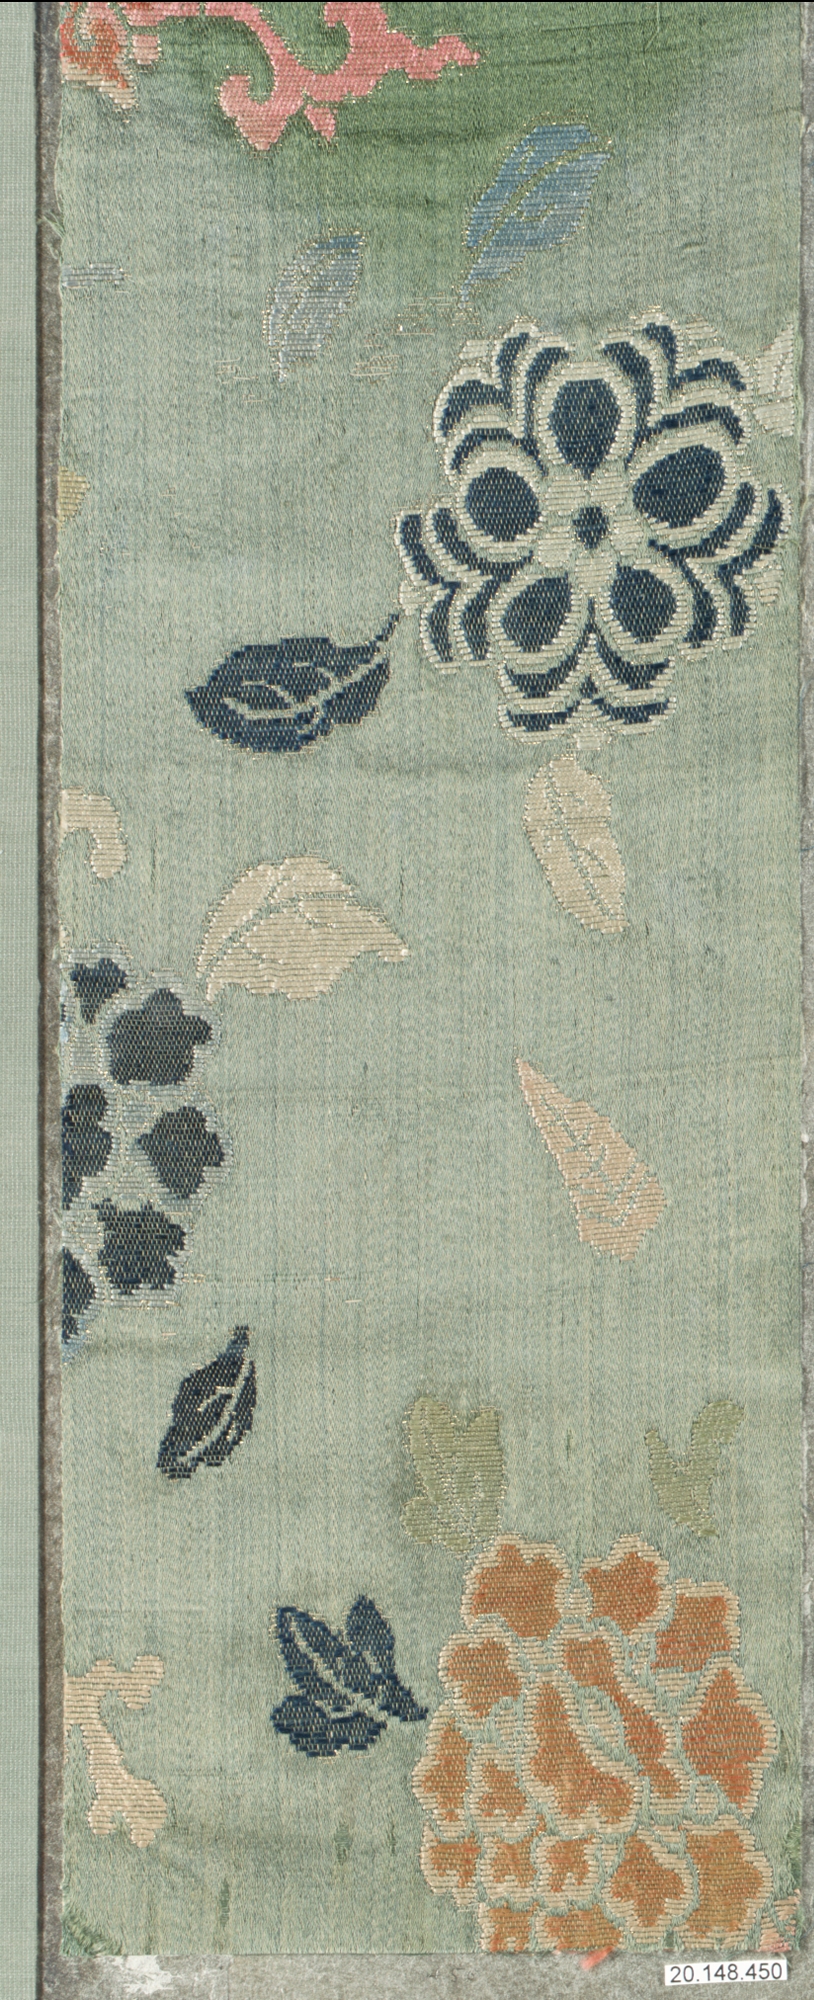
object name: piece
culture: chinese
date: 1701-1800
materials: silk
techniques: compound weave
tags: flowers,leaves